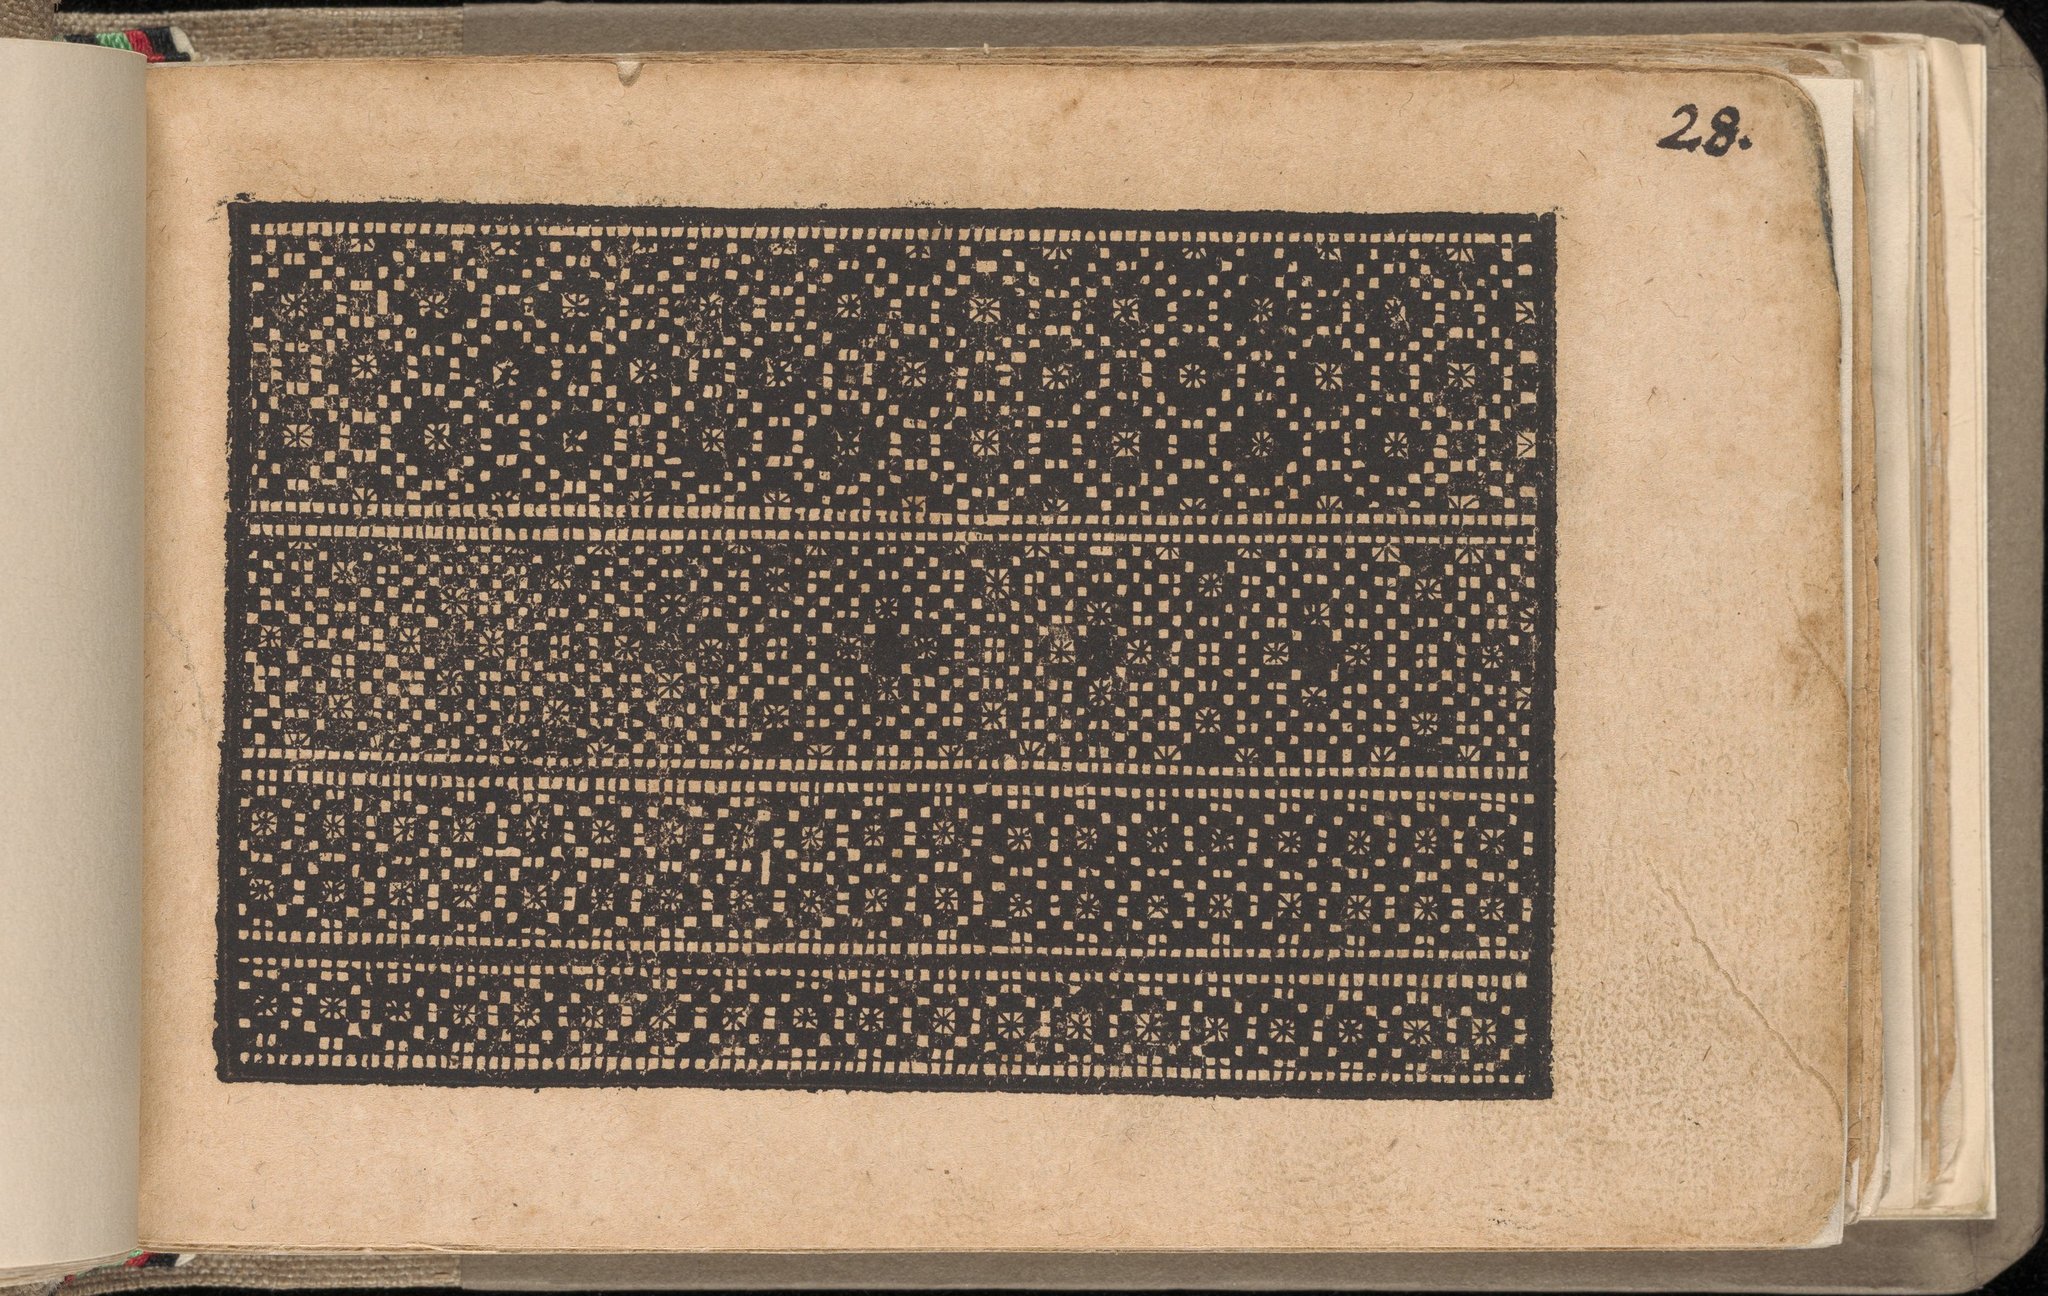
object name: book print ornament architecture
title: Schön newes Modelbuch (Page 28r)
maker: sigismundus latomus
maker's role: publisher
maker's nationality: german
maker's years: 1599-1632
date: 1608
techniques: woodcut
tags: ornament